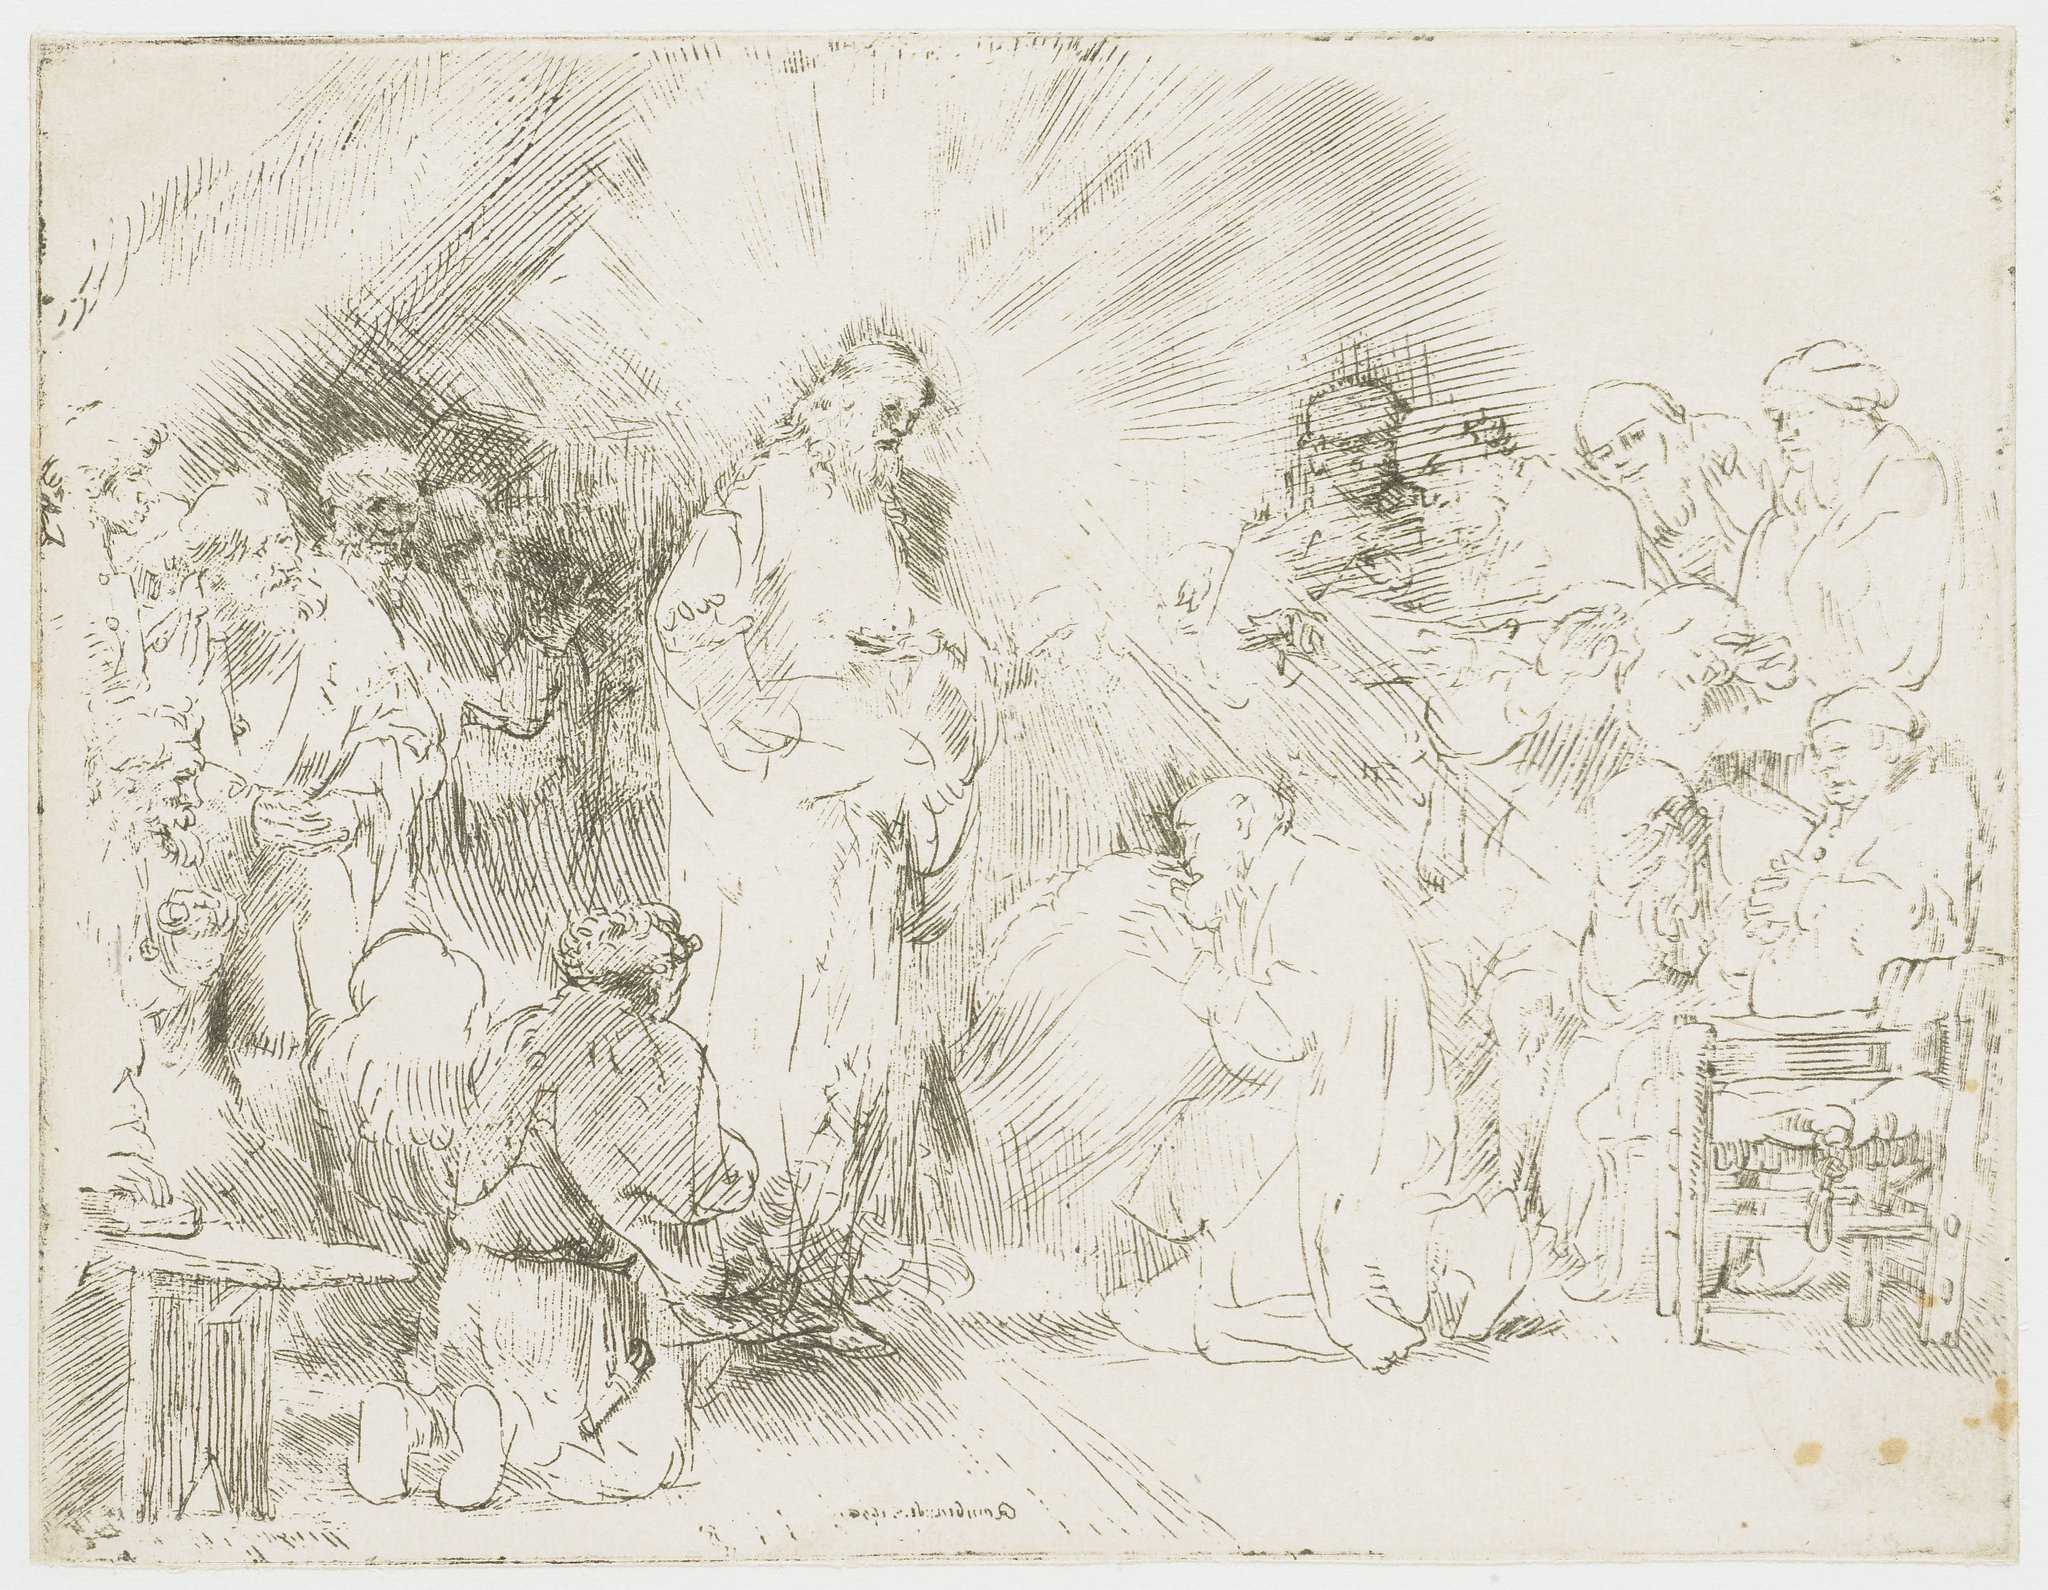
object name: print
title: Christ appearing to the apostles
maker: rembrandt van rijn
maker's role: draughtsman, painter, print maker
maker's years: 1606-1669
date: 1656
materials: paper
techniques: printmaking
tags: christ appears to the apostles (gathered behind locked doors)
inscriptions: inscription: ‘nr. 54-4’, signature and date: ‘Rembrandt f. 1656 (spiegelbeeldig)’, mark: Lugt 240